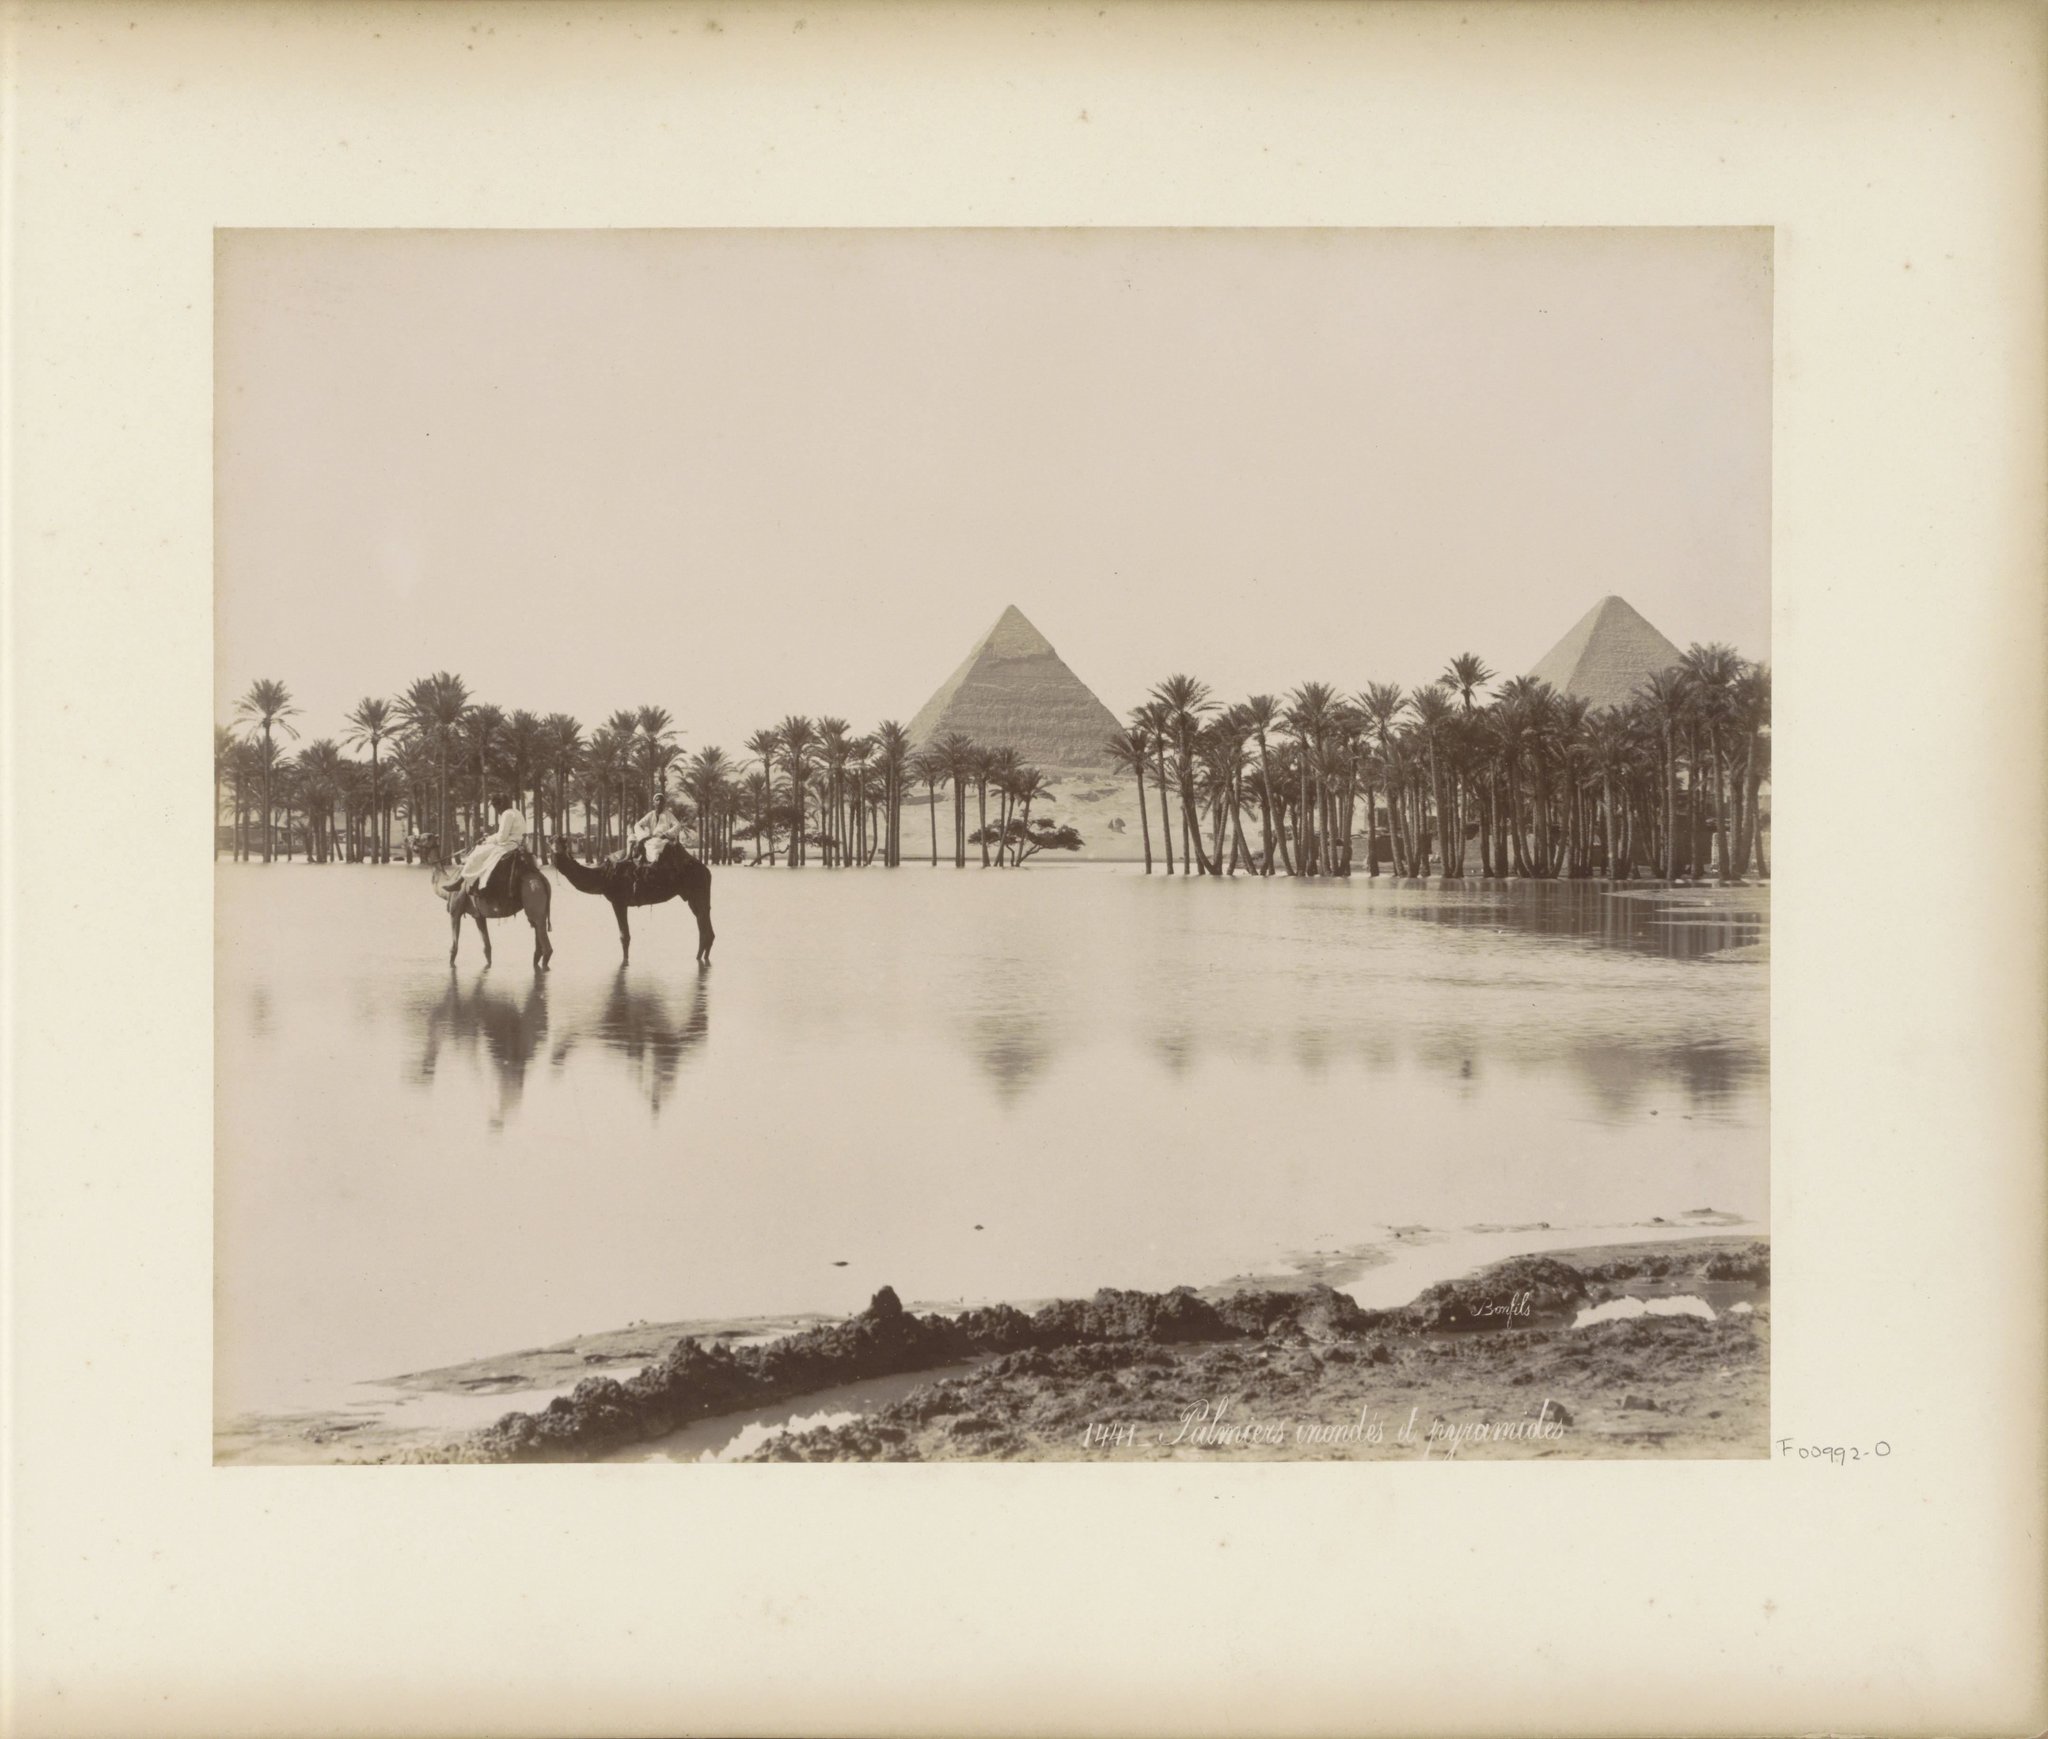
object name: photograph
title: Palmiers inondés et pyramides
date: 1870-1898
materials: cardboard, paper, photographic support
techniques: albumen print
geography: egypt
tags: flood, high tide, pyramid (historical grave form), trees: palm-tree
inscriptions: negative number: ‘1441’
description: Onderdeel van Reisalbum met 80 foto's van Egypte.